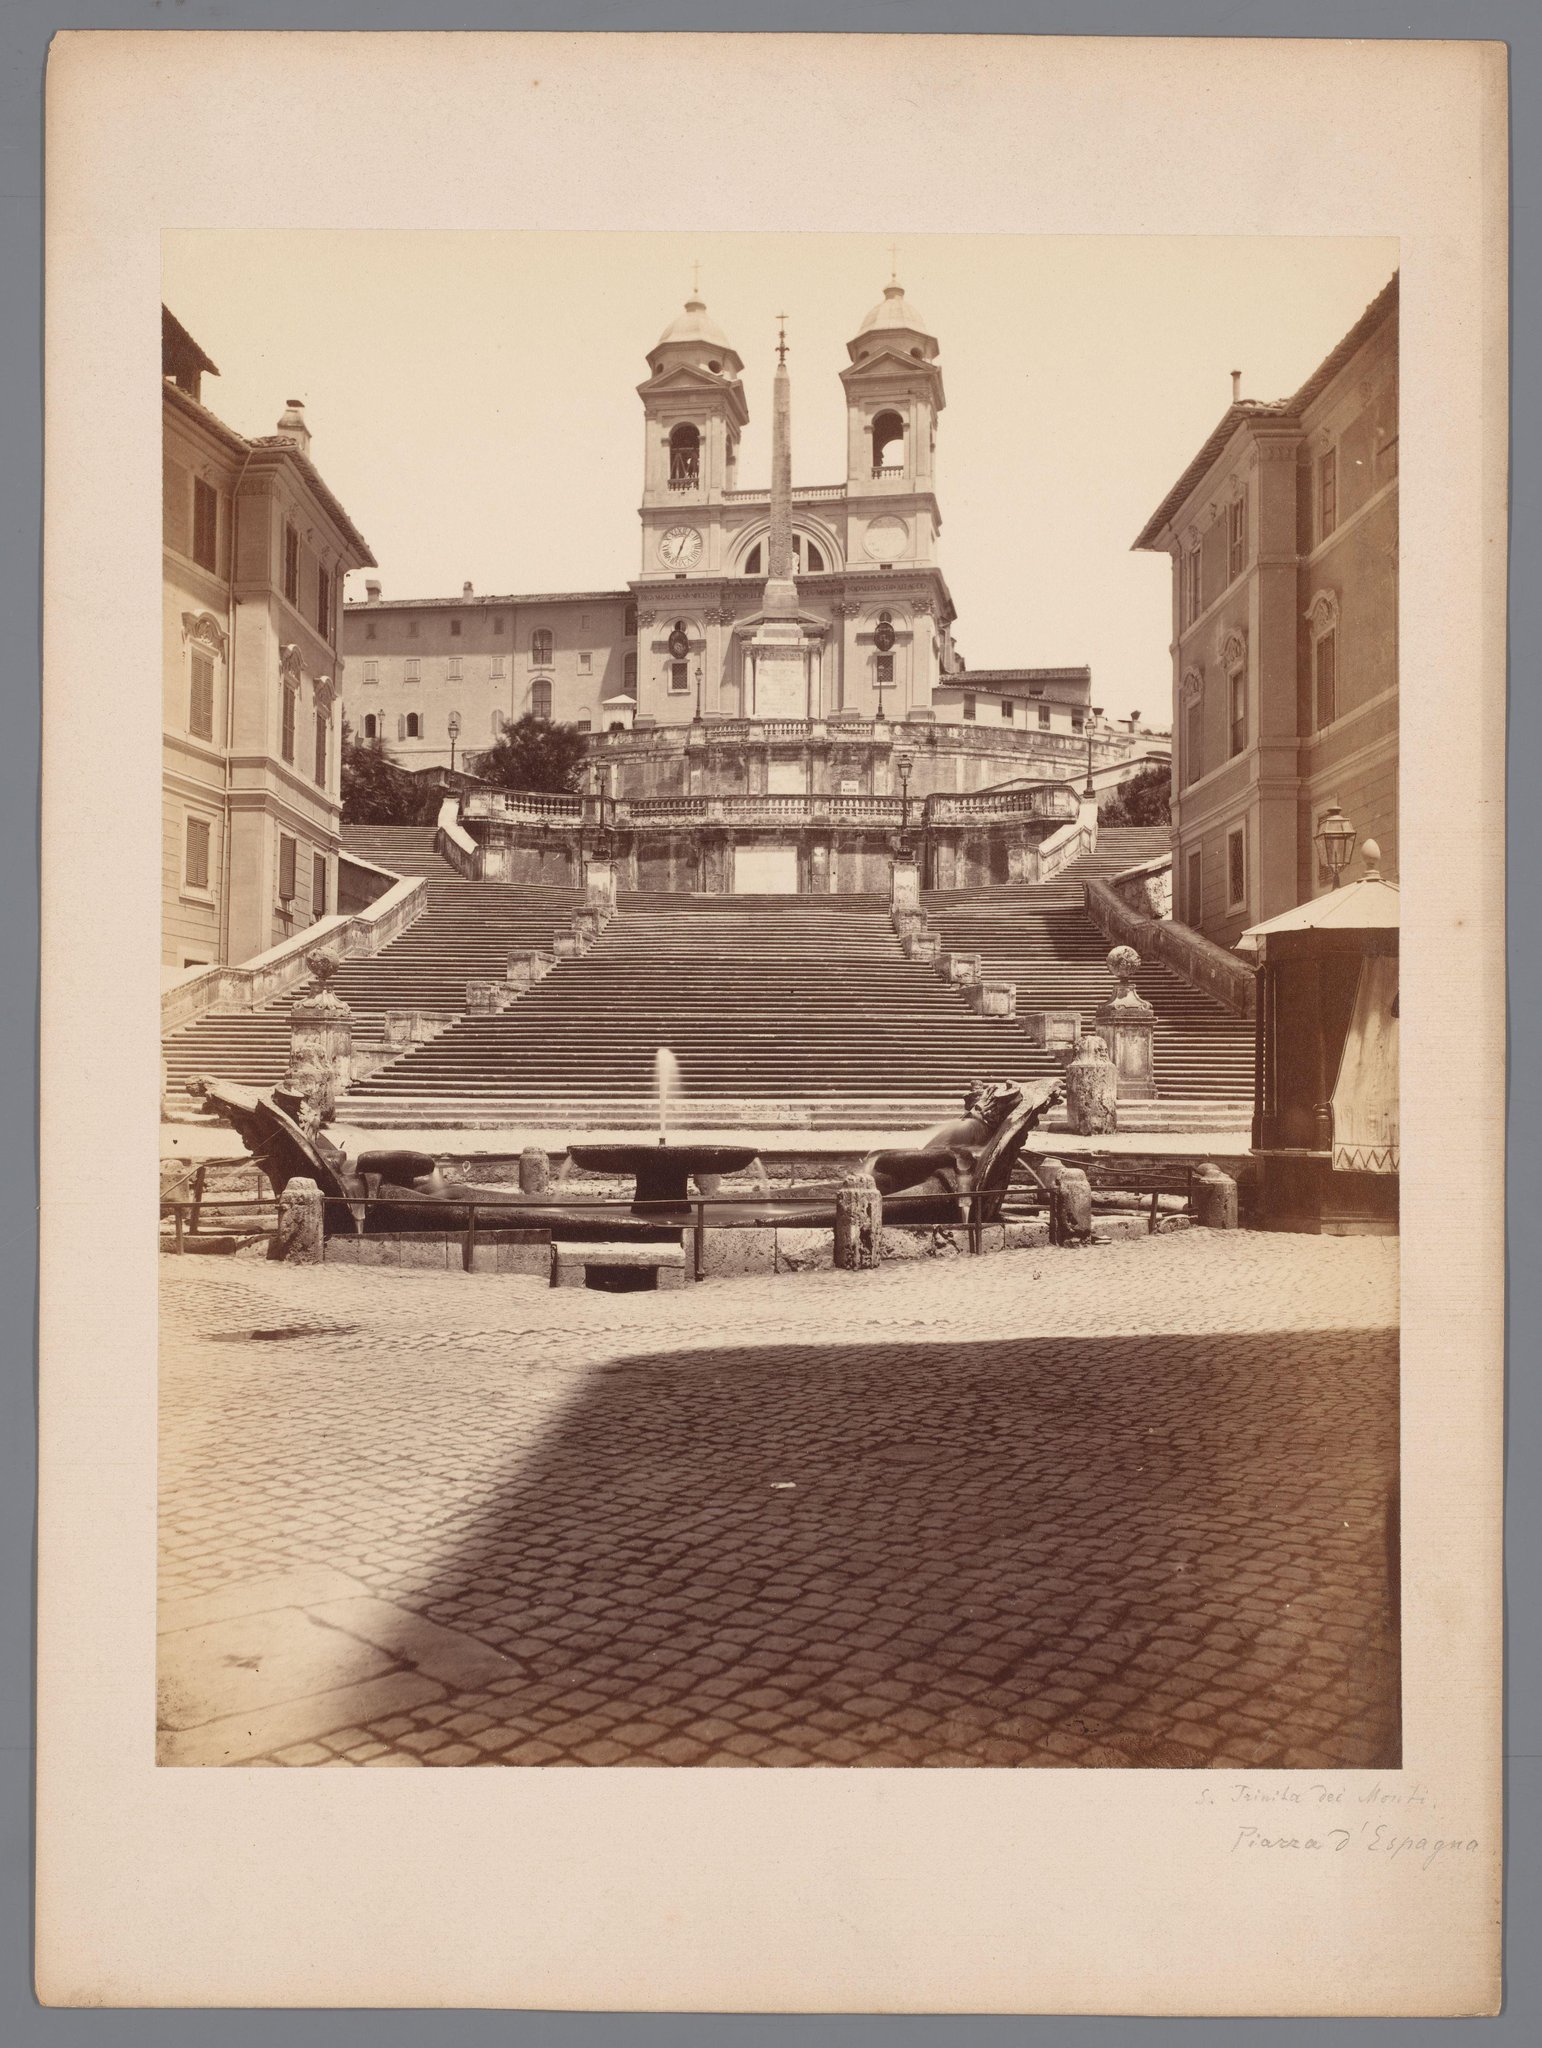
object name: photograph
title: Gezicht op de Spaanse trappen, de Piazza di Spagna en de Trinità dei Monti te Rome, Italië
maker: Anonymous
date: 1851-1900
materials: cardboard, paper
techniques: albumen print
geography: rome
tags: flight of steps, church (exterior), ornamental fountain